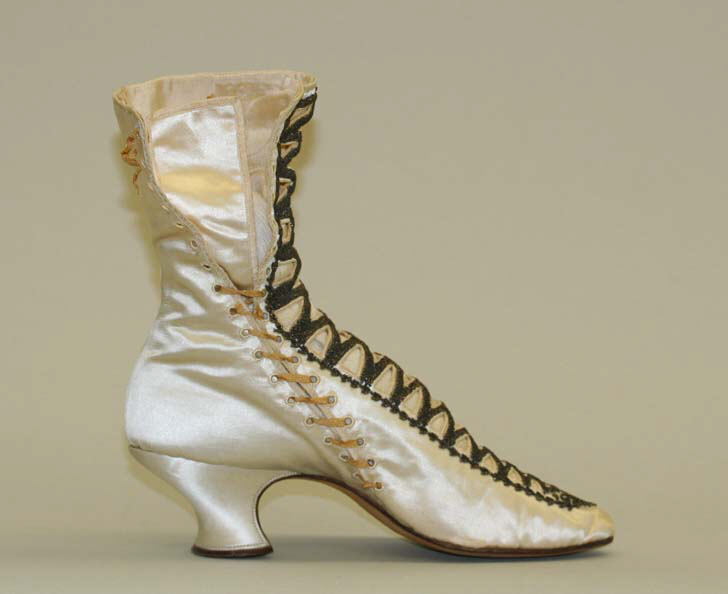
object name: boot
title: Boots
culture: french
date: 1880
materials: silk